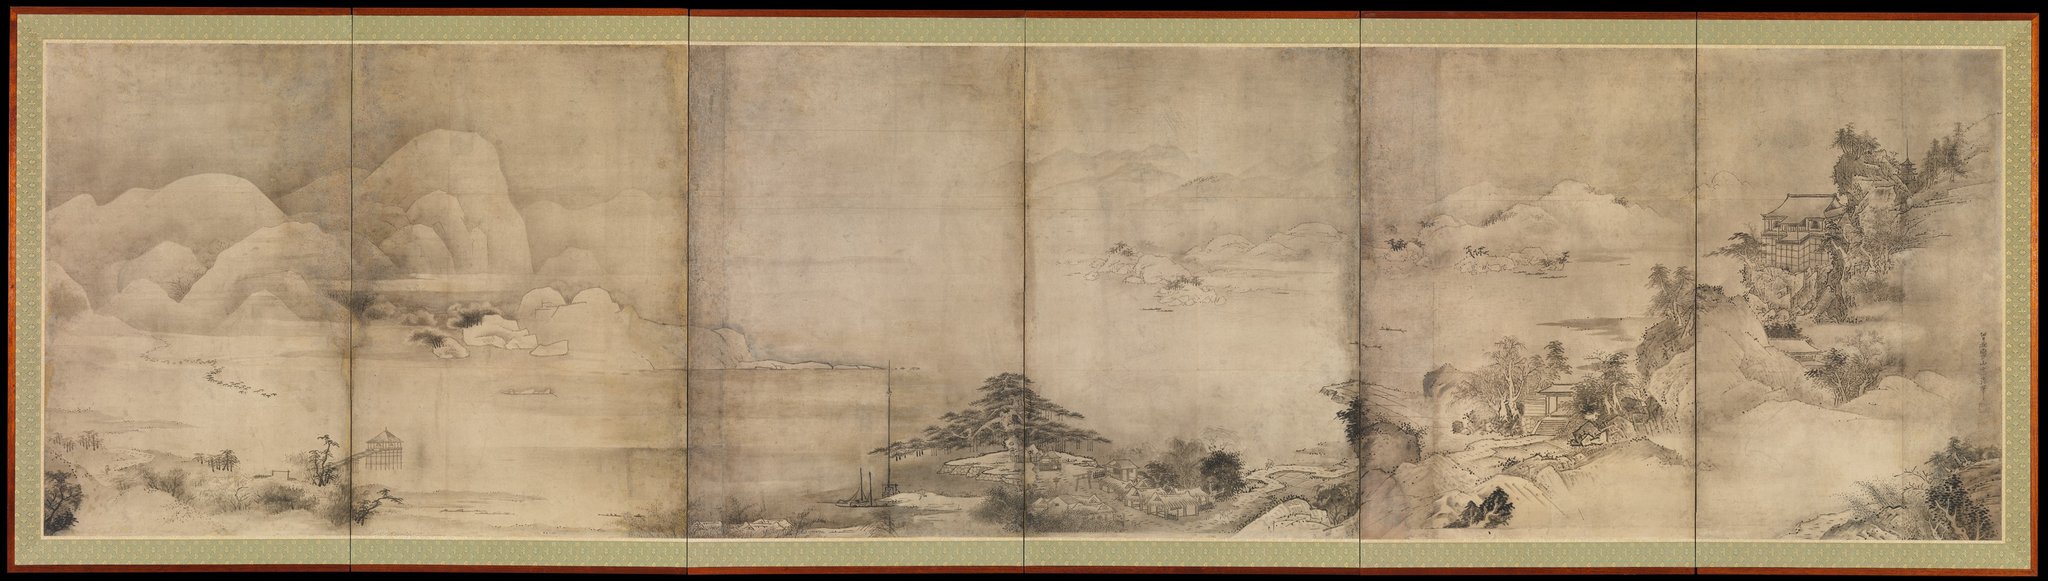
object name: screen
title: Eight Views of Ōmi (Ōmi hakkei)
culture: japanese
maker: soga shōhaku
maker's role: artist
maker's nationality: japanese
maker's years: 1730-1781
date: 1762-1766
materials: ink, panel, paper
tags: houses,lakes,mountains,landscapes,trees